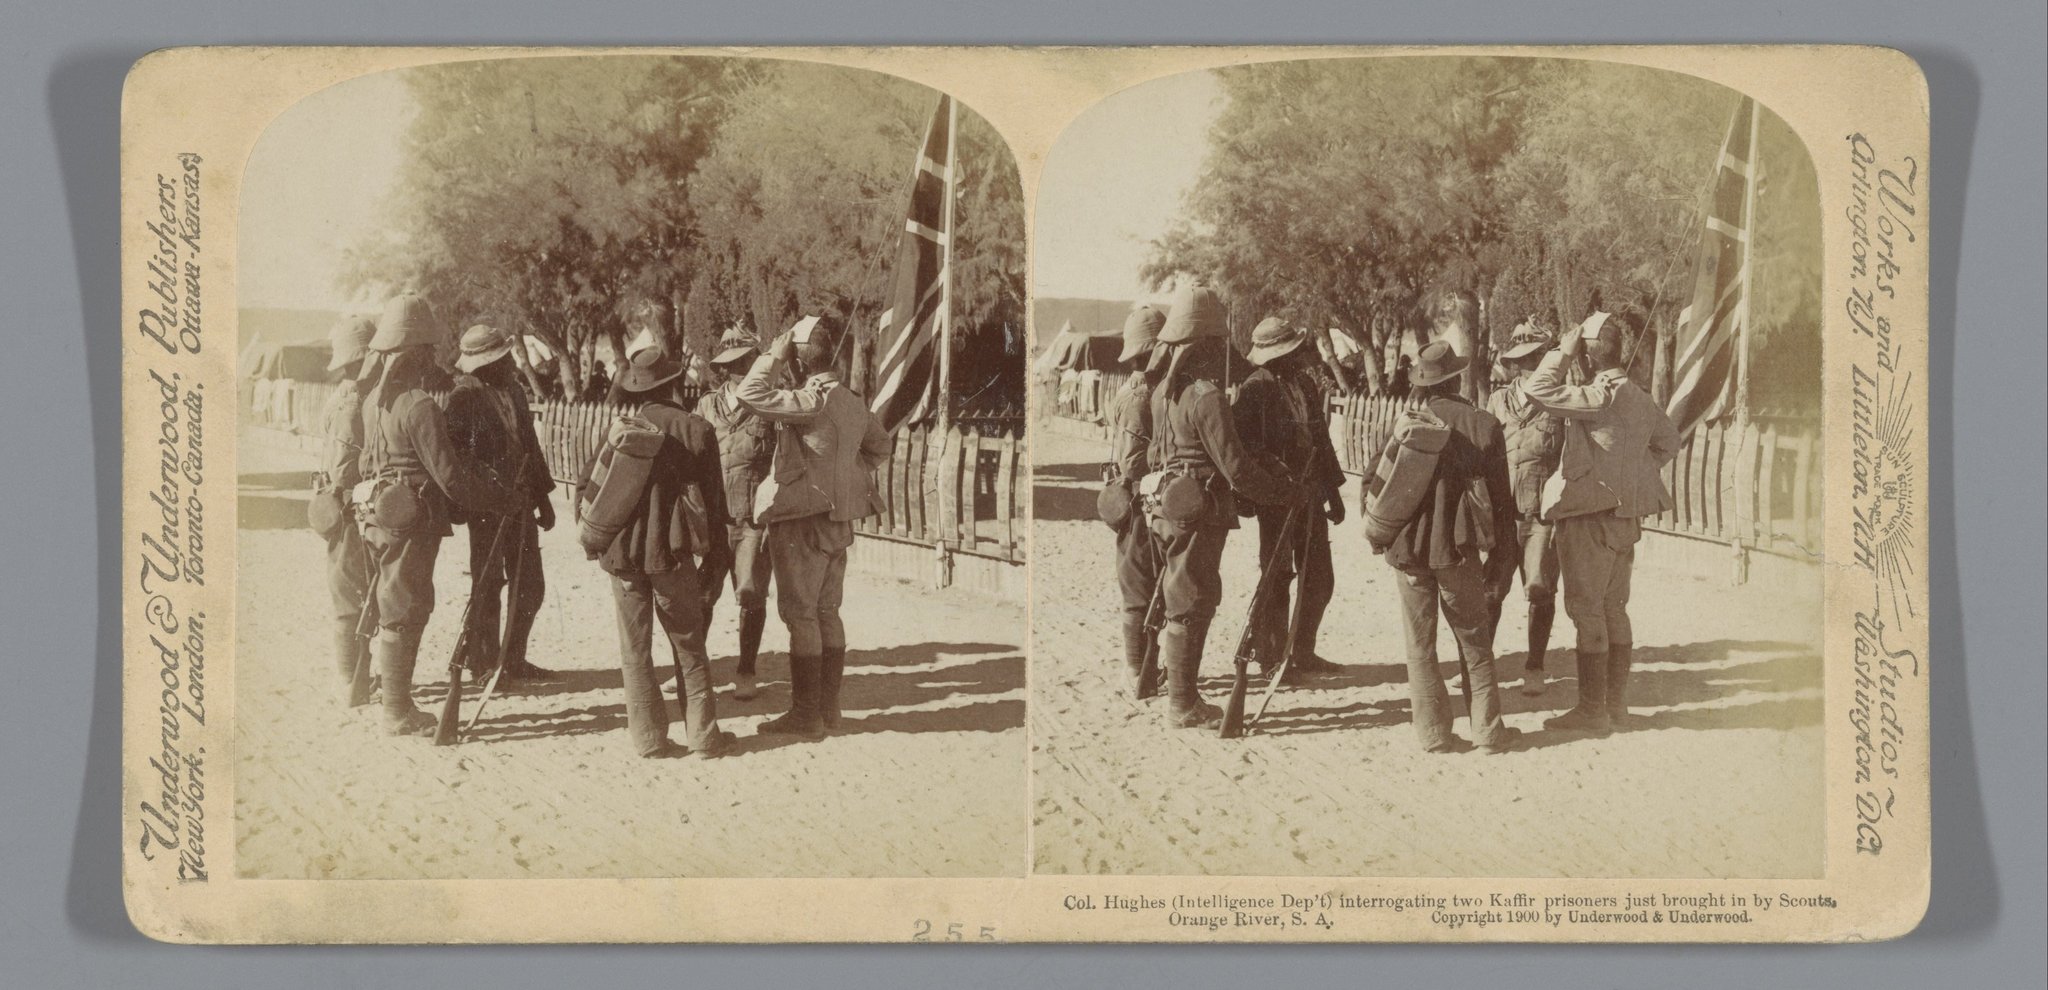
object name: stereograph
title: Col. Hughes (Intelligence Dep't), interrogating two Kaffir prisoners just brought in by Scouts, Orange River, S.A.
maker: Anonymous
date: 1900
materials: cardboard, paper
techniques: albumen print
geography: new york city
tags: scouting, reconnaissance (military), interrogation ~ prisoner of war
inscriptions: inscription: ‘Works and Studios ~/ Arlington, N.J. Littleton, N.H. Washington, D.C.’, inscription, number: ‘255’, copyright notice: ‘Copyright 1900 by Underwood & Underwood.’